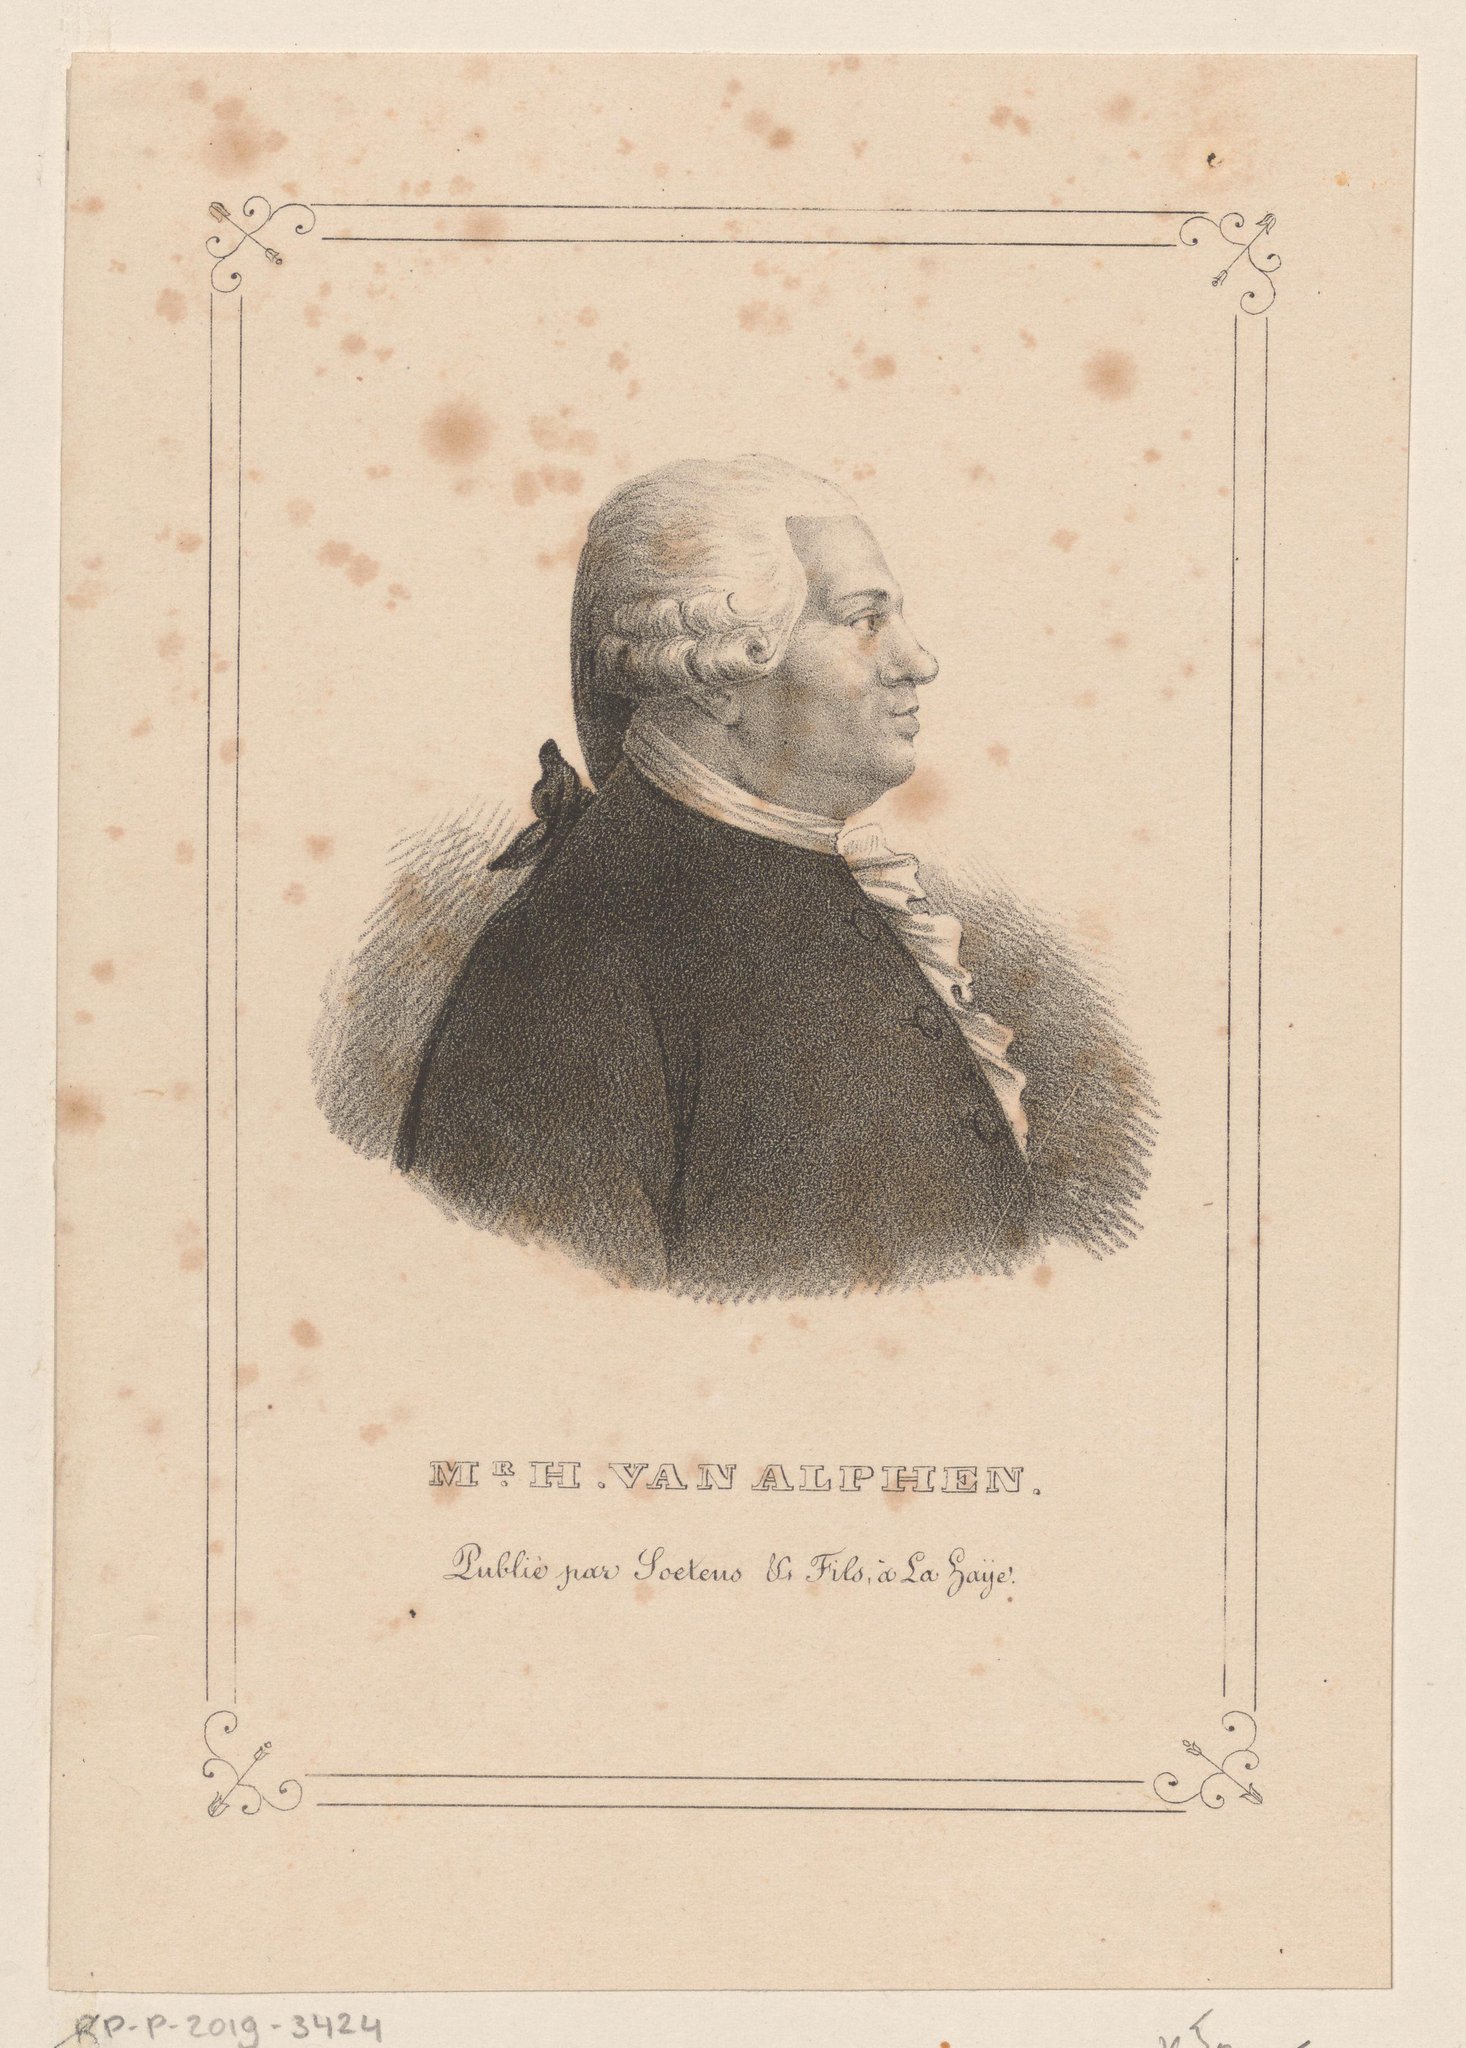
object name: print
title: Portret van Hieronymus van Alphen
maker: Anonymous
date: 1837-1840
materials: paper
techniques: lithograph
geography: the hague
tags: gouda, the hague, historical persons, writer, poet, author